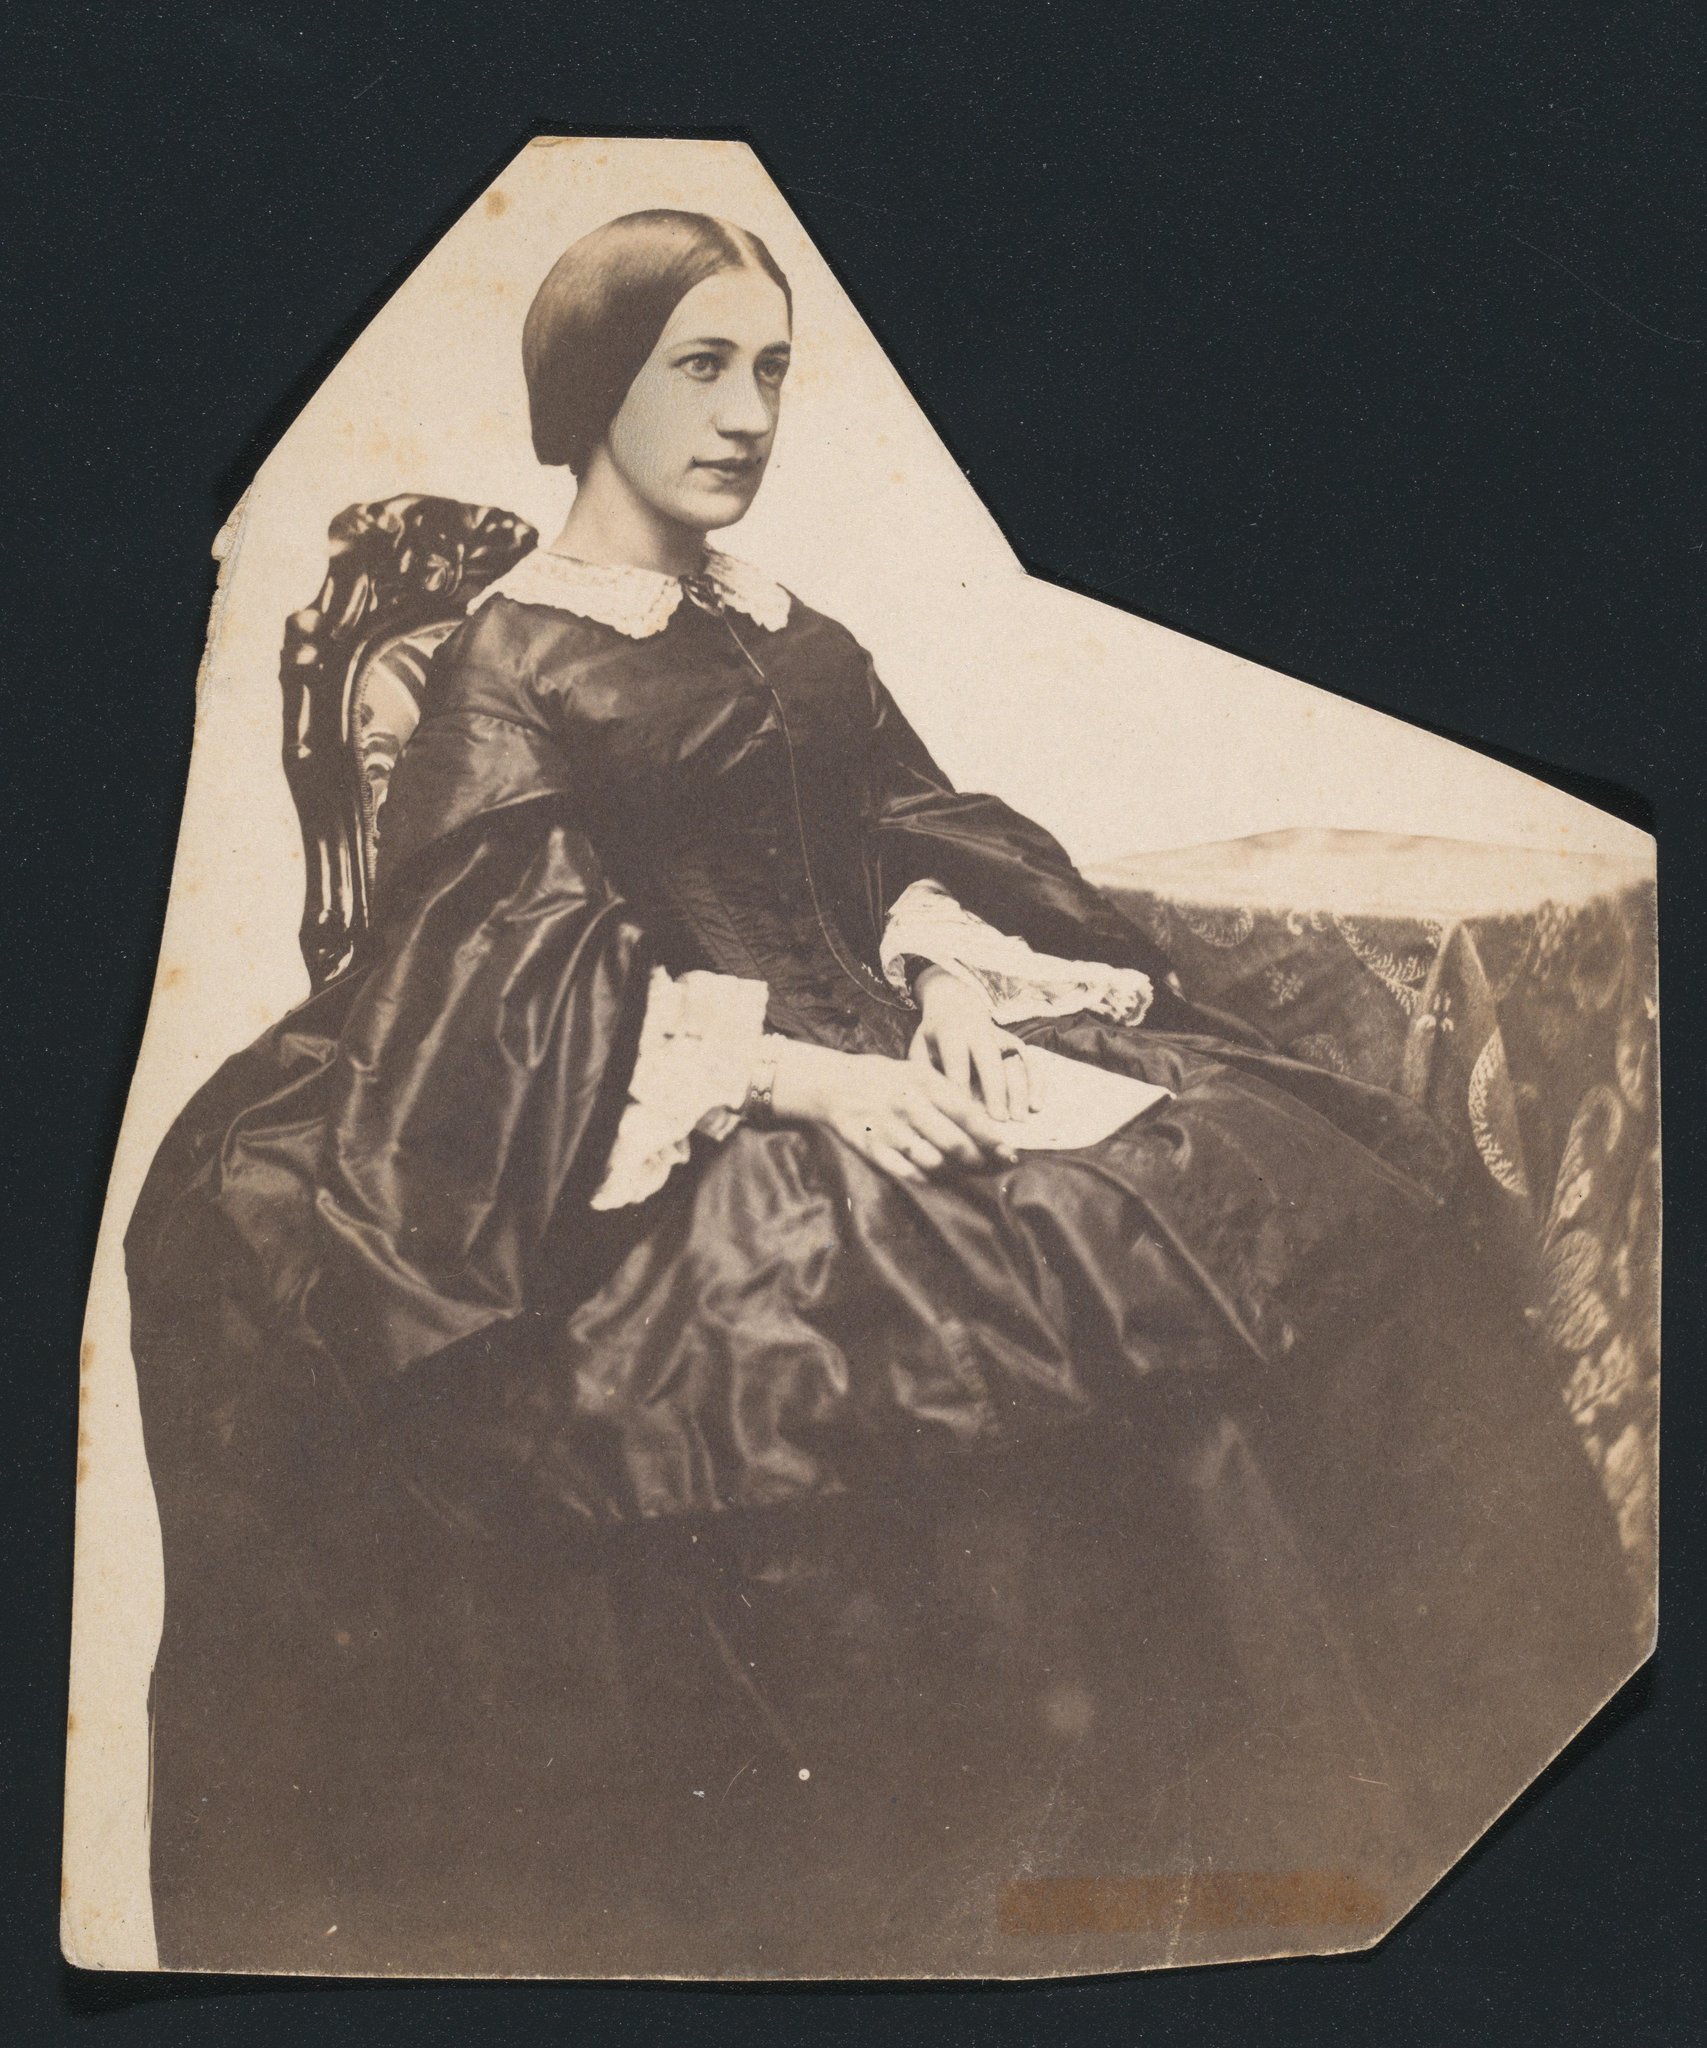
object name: photograph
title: Portret van C.I. Bosch Reitz-Teding van Berkhout in een lange jurk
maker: Anonymous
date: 1860-1870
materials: cardboard, photographic support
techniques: albumen print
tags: dress, gown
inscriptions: inscription: ‘de grootmoeder (van Totie) die zovele jurkjes borduurde met Engels borduurwerk, welke in de schenking van Six van 1979 zo rijk zijn vertegenwoordigd.’, inscription: ‘C.I. Teding van Berkhout 1837-1886 trouwt Amst. 12 mei 1859’